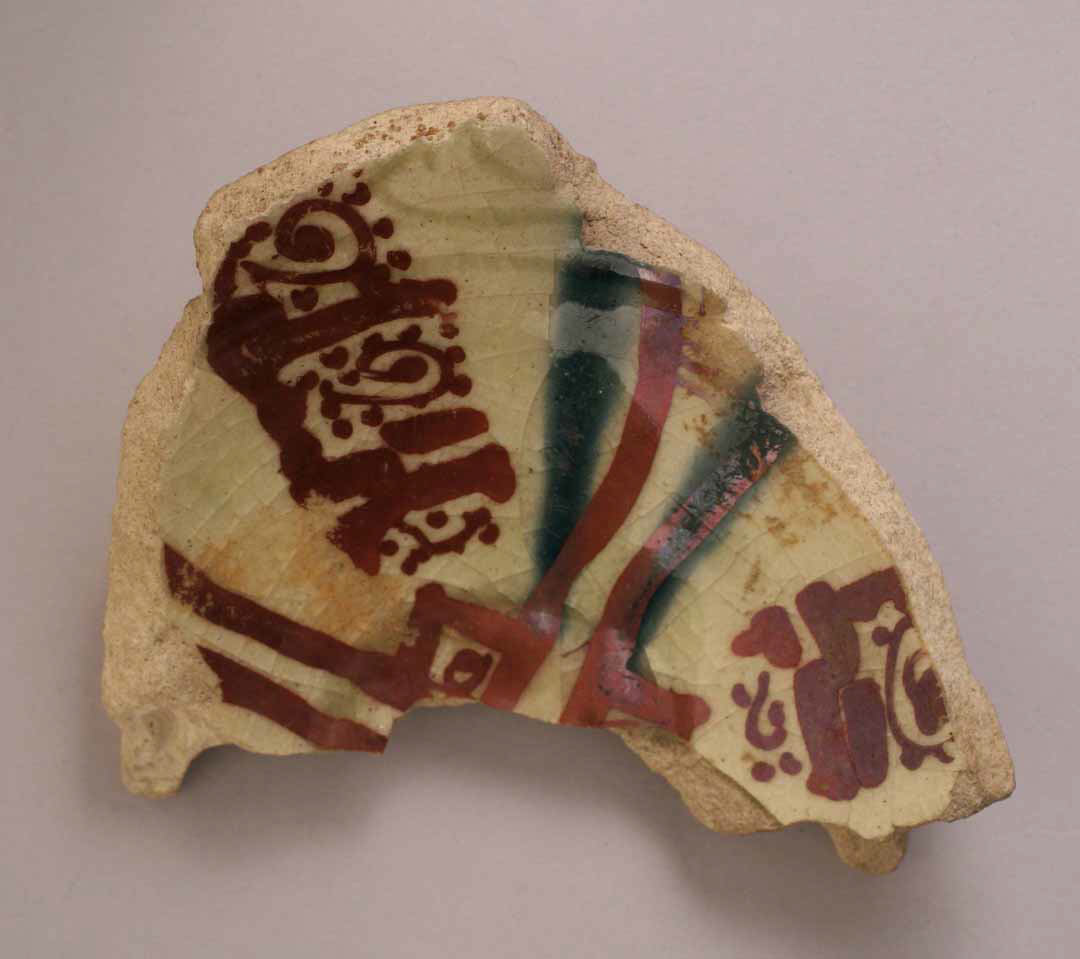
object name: ceramic fragment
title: Fragment of a Bowl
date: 901-1200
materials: earthenware, glaze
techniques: luster painting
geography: egypt